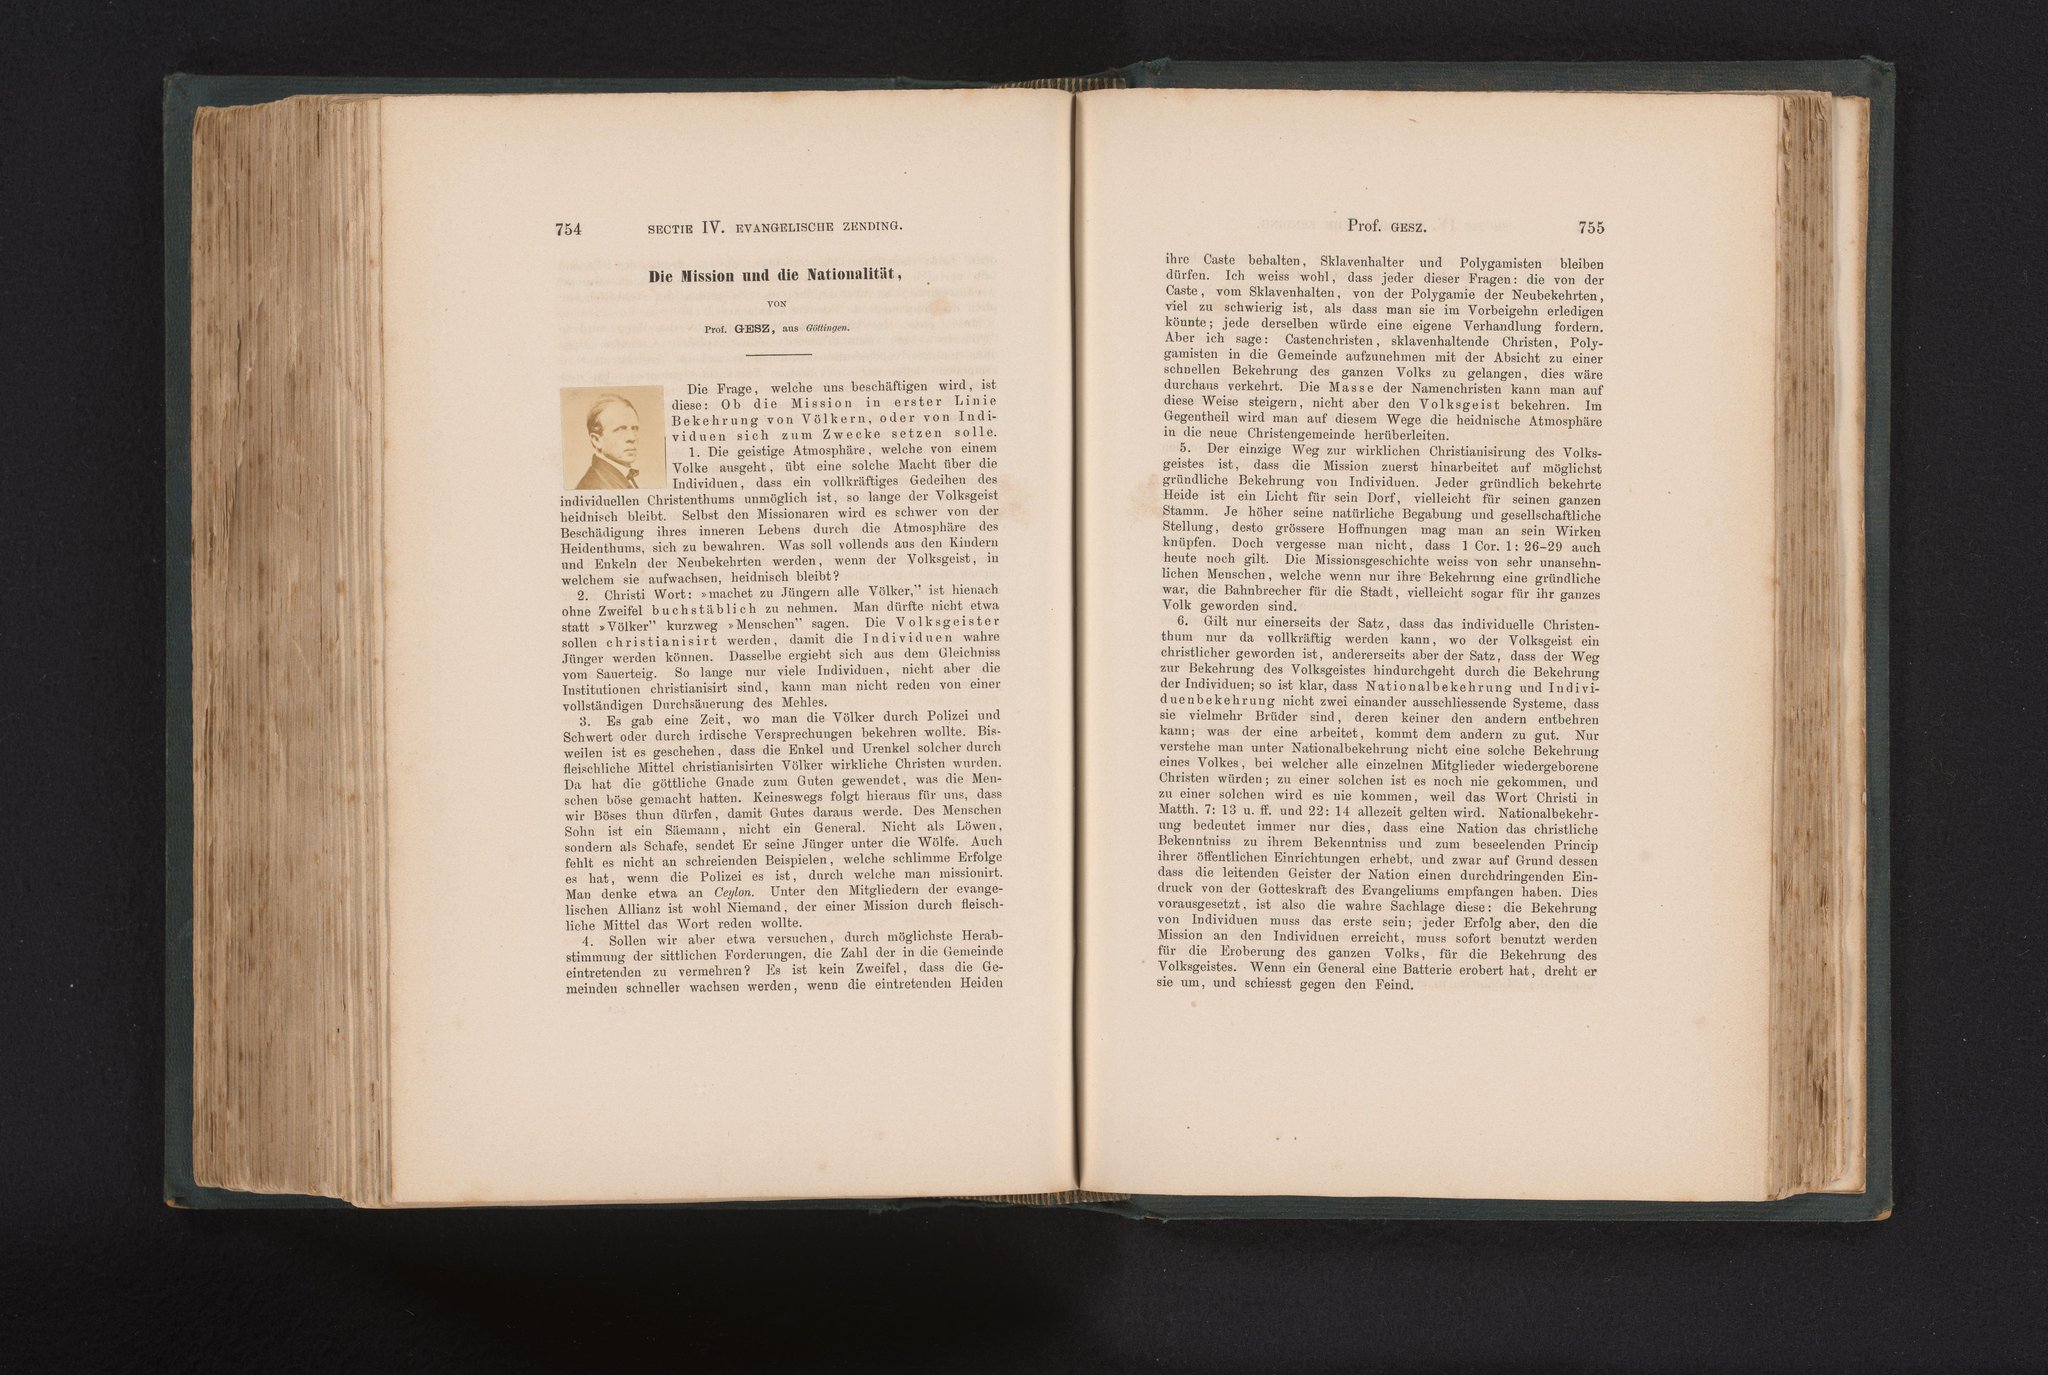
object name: page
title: Portret van een onbekende man, aangeduid als professor Gesz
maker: Anonymous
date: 1855-1867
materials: paper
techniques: albumen print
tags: adult man, historical persons